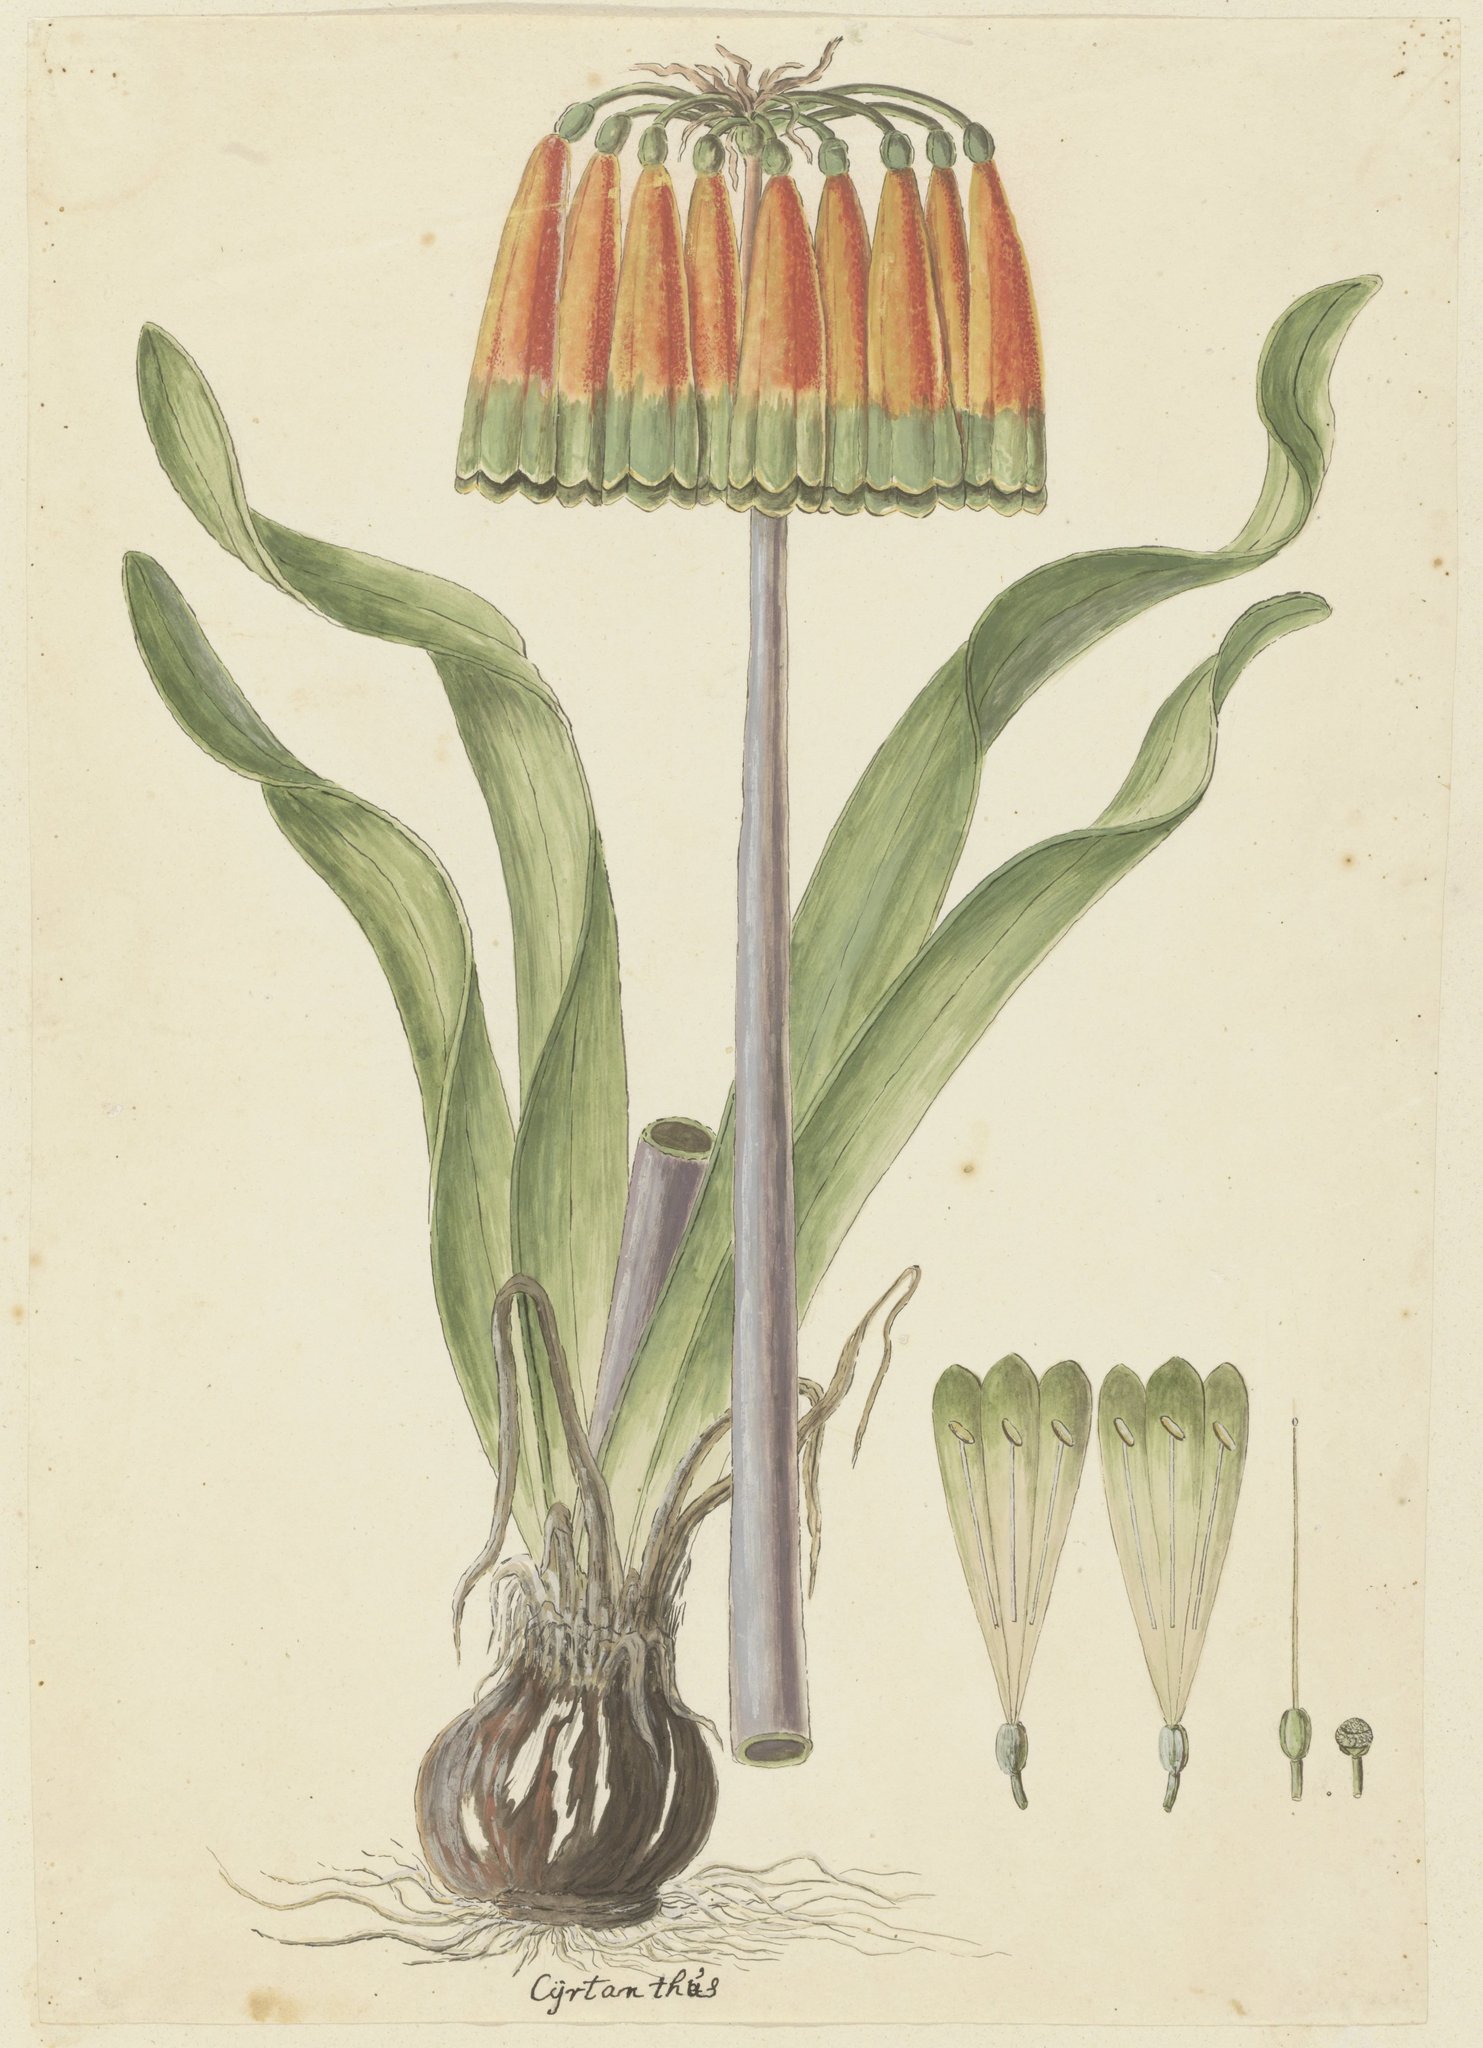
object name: drawing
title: Cyranthus obliquus (L.f.) Aiton (Knysna lily)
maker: robert jacob gordon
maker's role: draughtsman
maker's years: 1743-1795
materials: chalk, paint, ink, paper, pencil, watercolor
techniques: brush, pen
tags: plants; vegetation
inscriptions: annotation: ‘Cijrtanthus’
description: De tekening is gemaakt voor of tijdens een van Gordon's vier expedities door de Kaapprovincie, van oktober 1777 tot maart 1786. Sommige (soort)namen kunnen zijn gewijzigd, gezien reorganisatie in plantentaxonomie gedurende de afgelopen jaren.